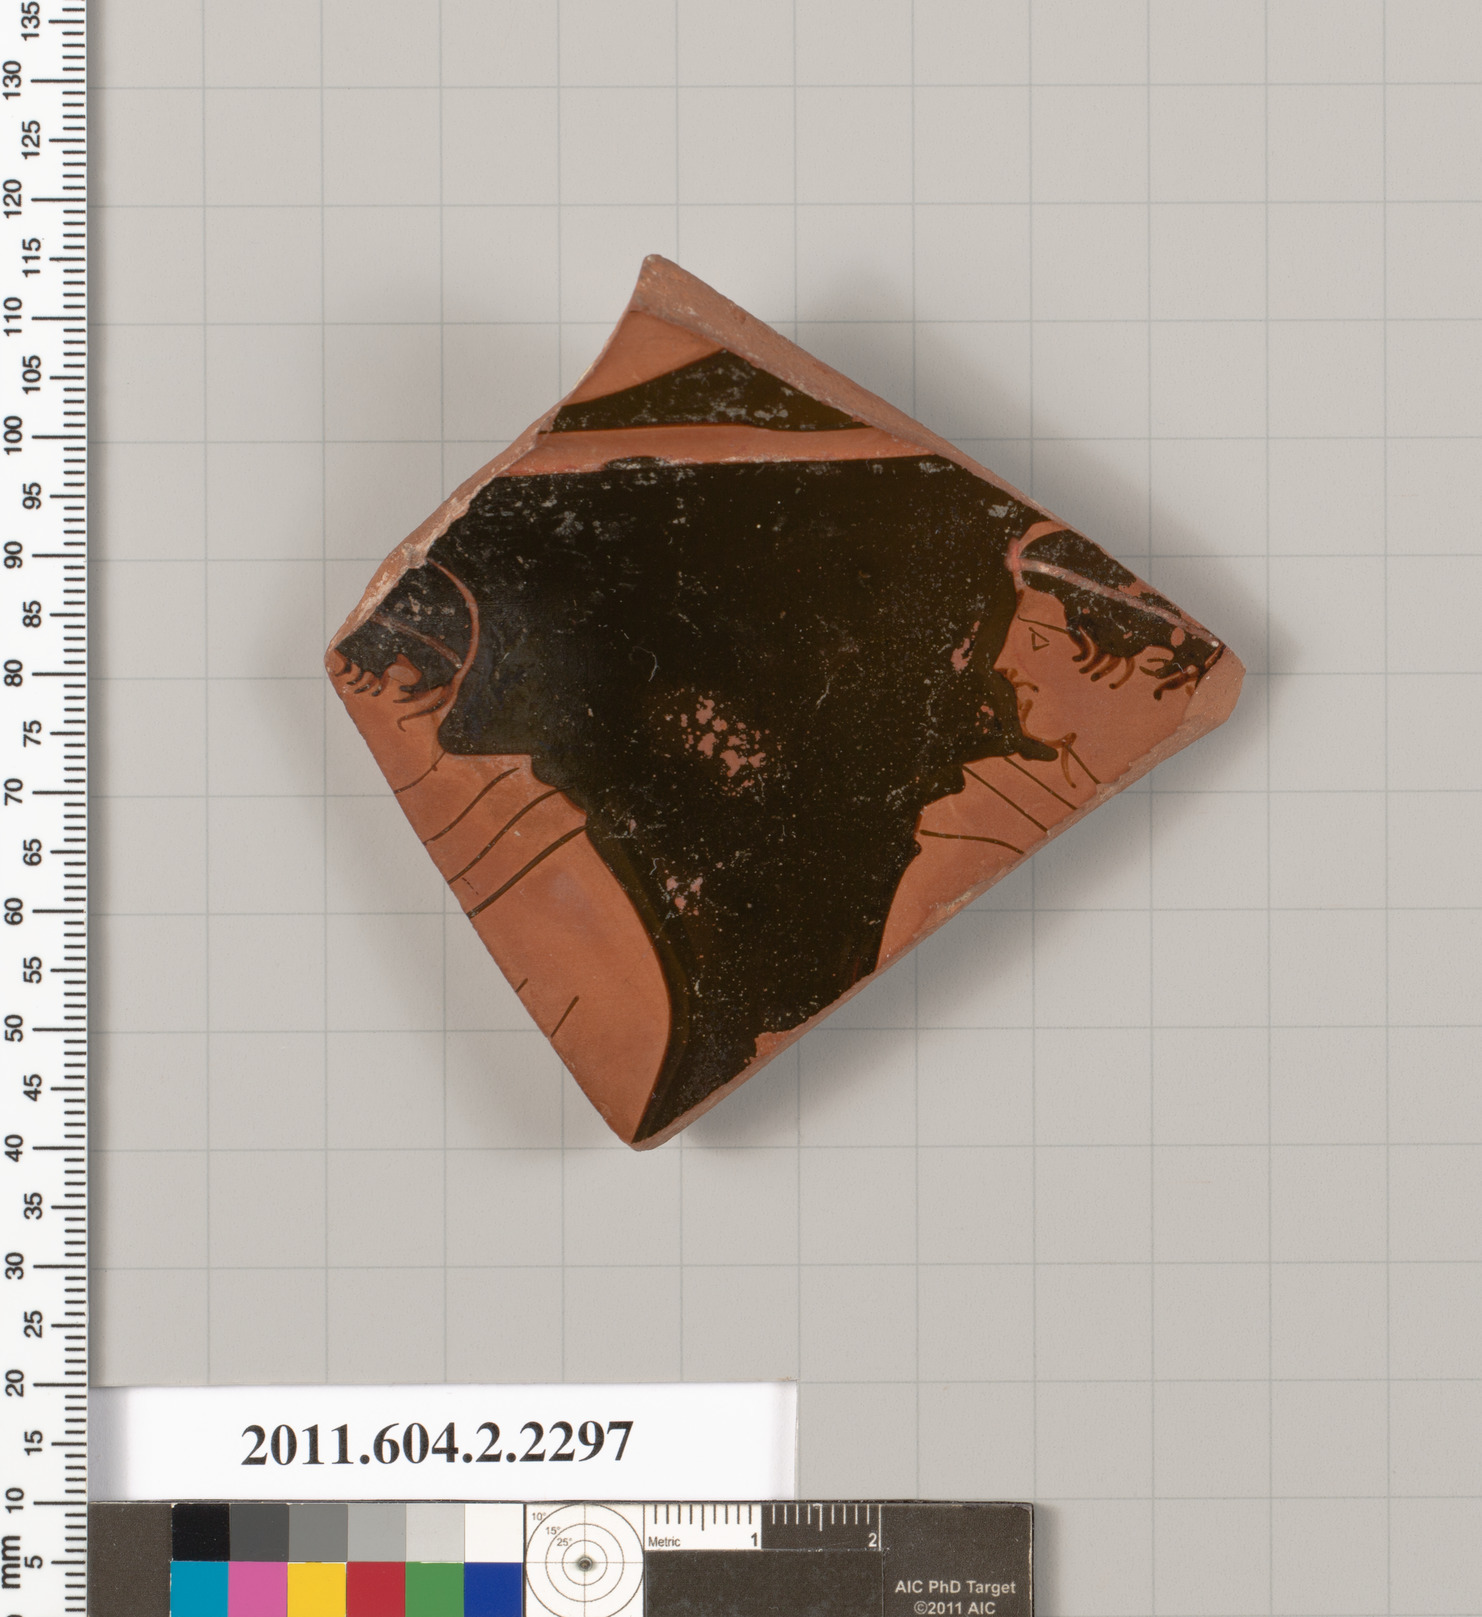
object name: bell krater fragment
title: Terracotta fragment of a bell-krater (bowl for mixing wine and water)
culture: greek, attic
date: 450-426 BCE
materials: terracotta